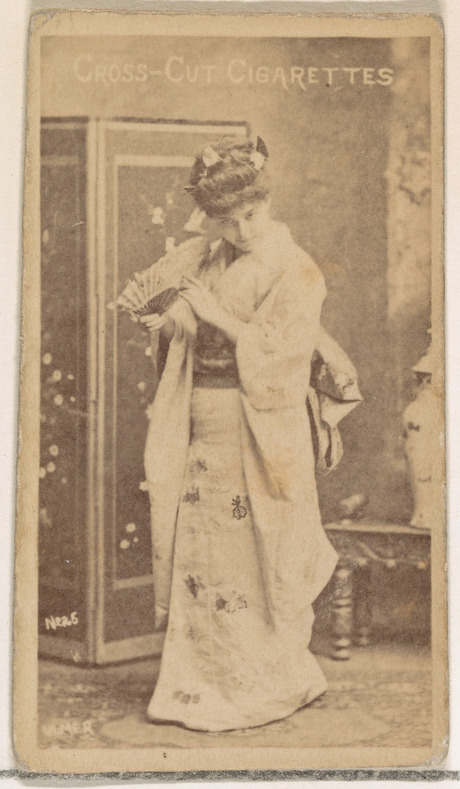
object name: print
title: Card Number 25, Geraldine Ulmer, from the Actors and Actresses series (N145-1) issued by Duke Sons & Co. to promote Cross Cut Cigarettes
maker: w. duke, sons & co.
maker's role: publisher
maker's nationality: american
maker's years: 1870-1920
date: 1880-1889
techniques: albumen silver print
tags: portraits,women,actresses